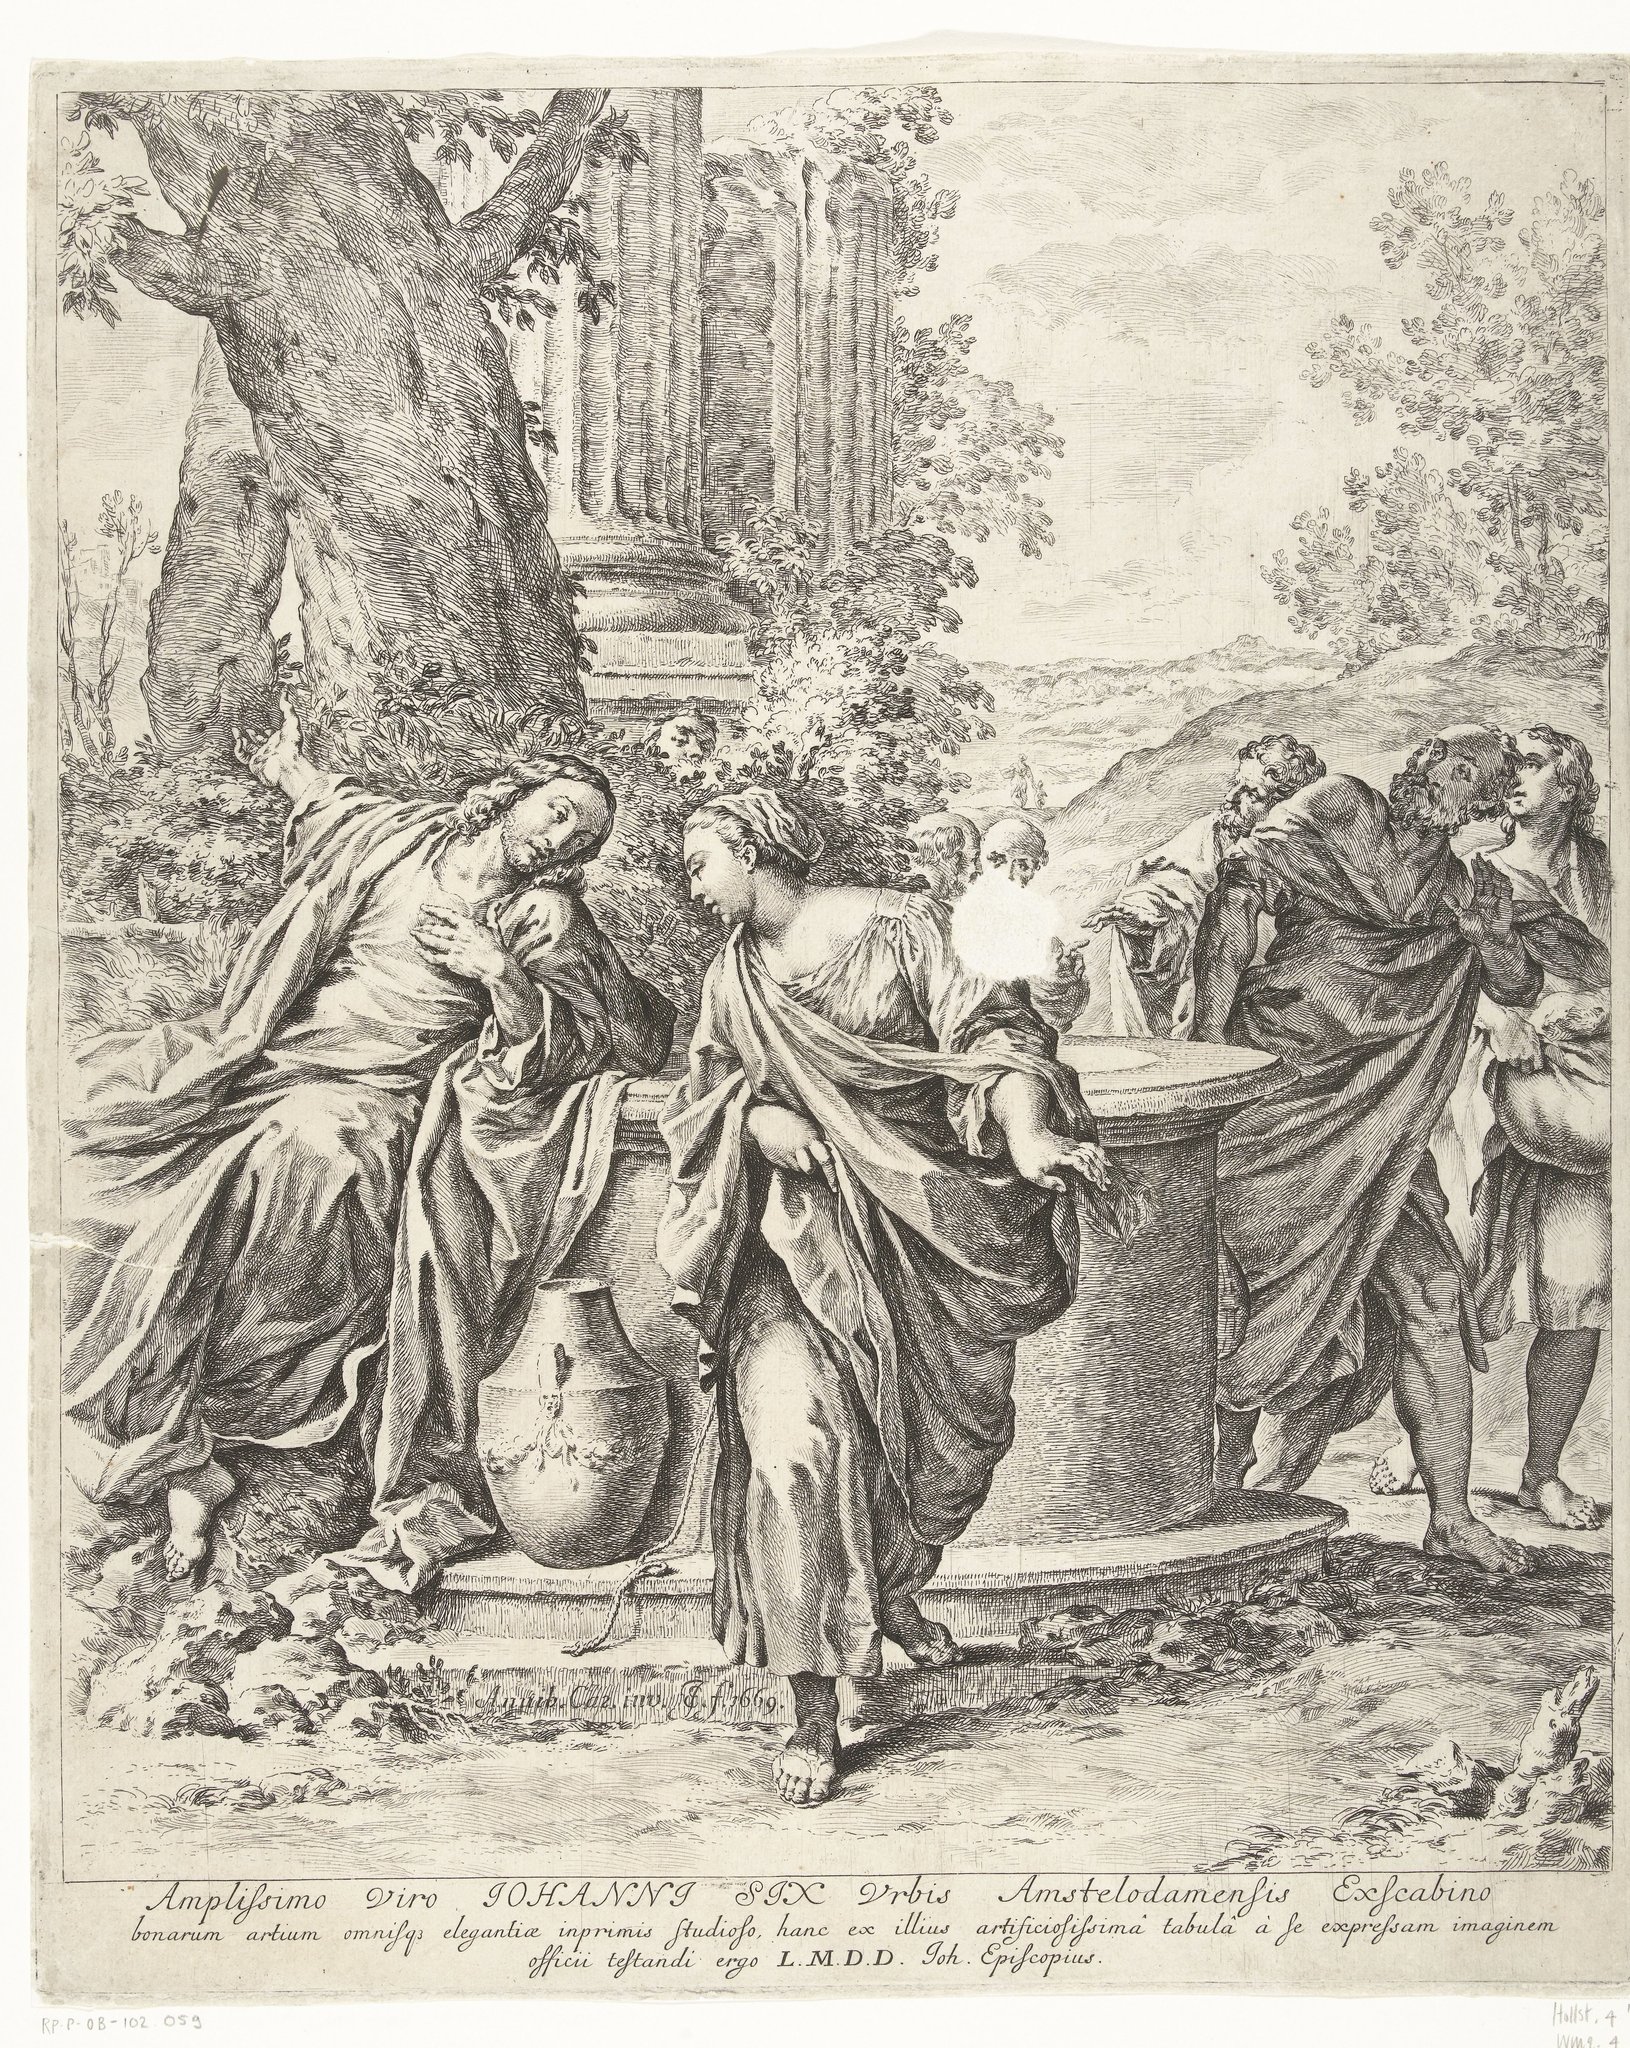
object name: print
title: Christus en de Samaritaanse vrouw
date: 1669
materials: paper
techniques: etching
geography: amsterdam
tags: christ and the woman of samaria: sitting at jacob's well he asks her for a drink from her jug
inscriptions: collector's mark: Lugt 2228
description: Christus zit bij een bron en vraagt aan een Samaritaanse vrouw of ze hem water kan geven. Op de achtergrond zijn zijn apostelen te zien.